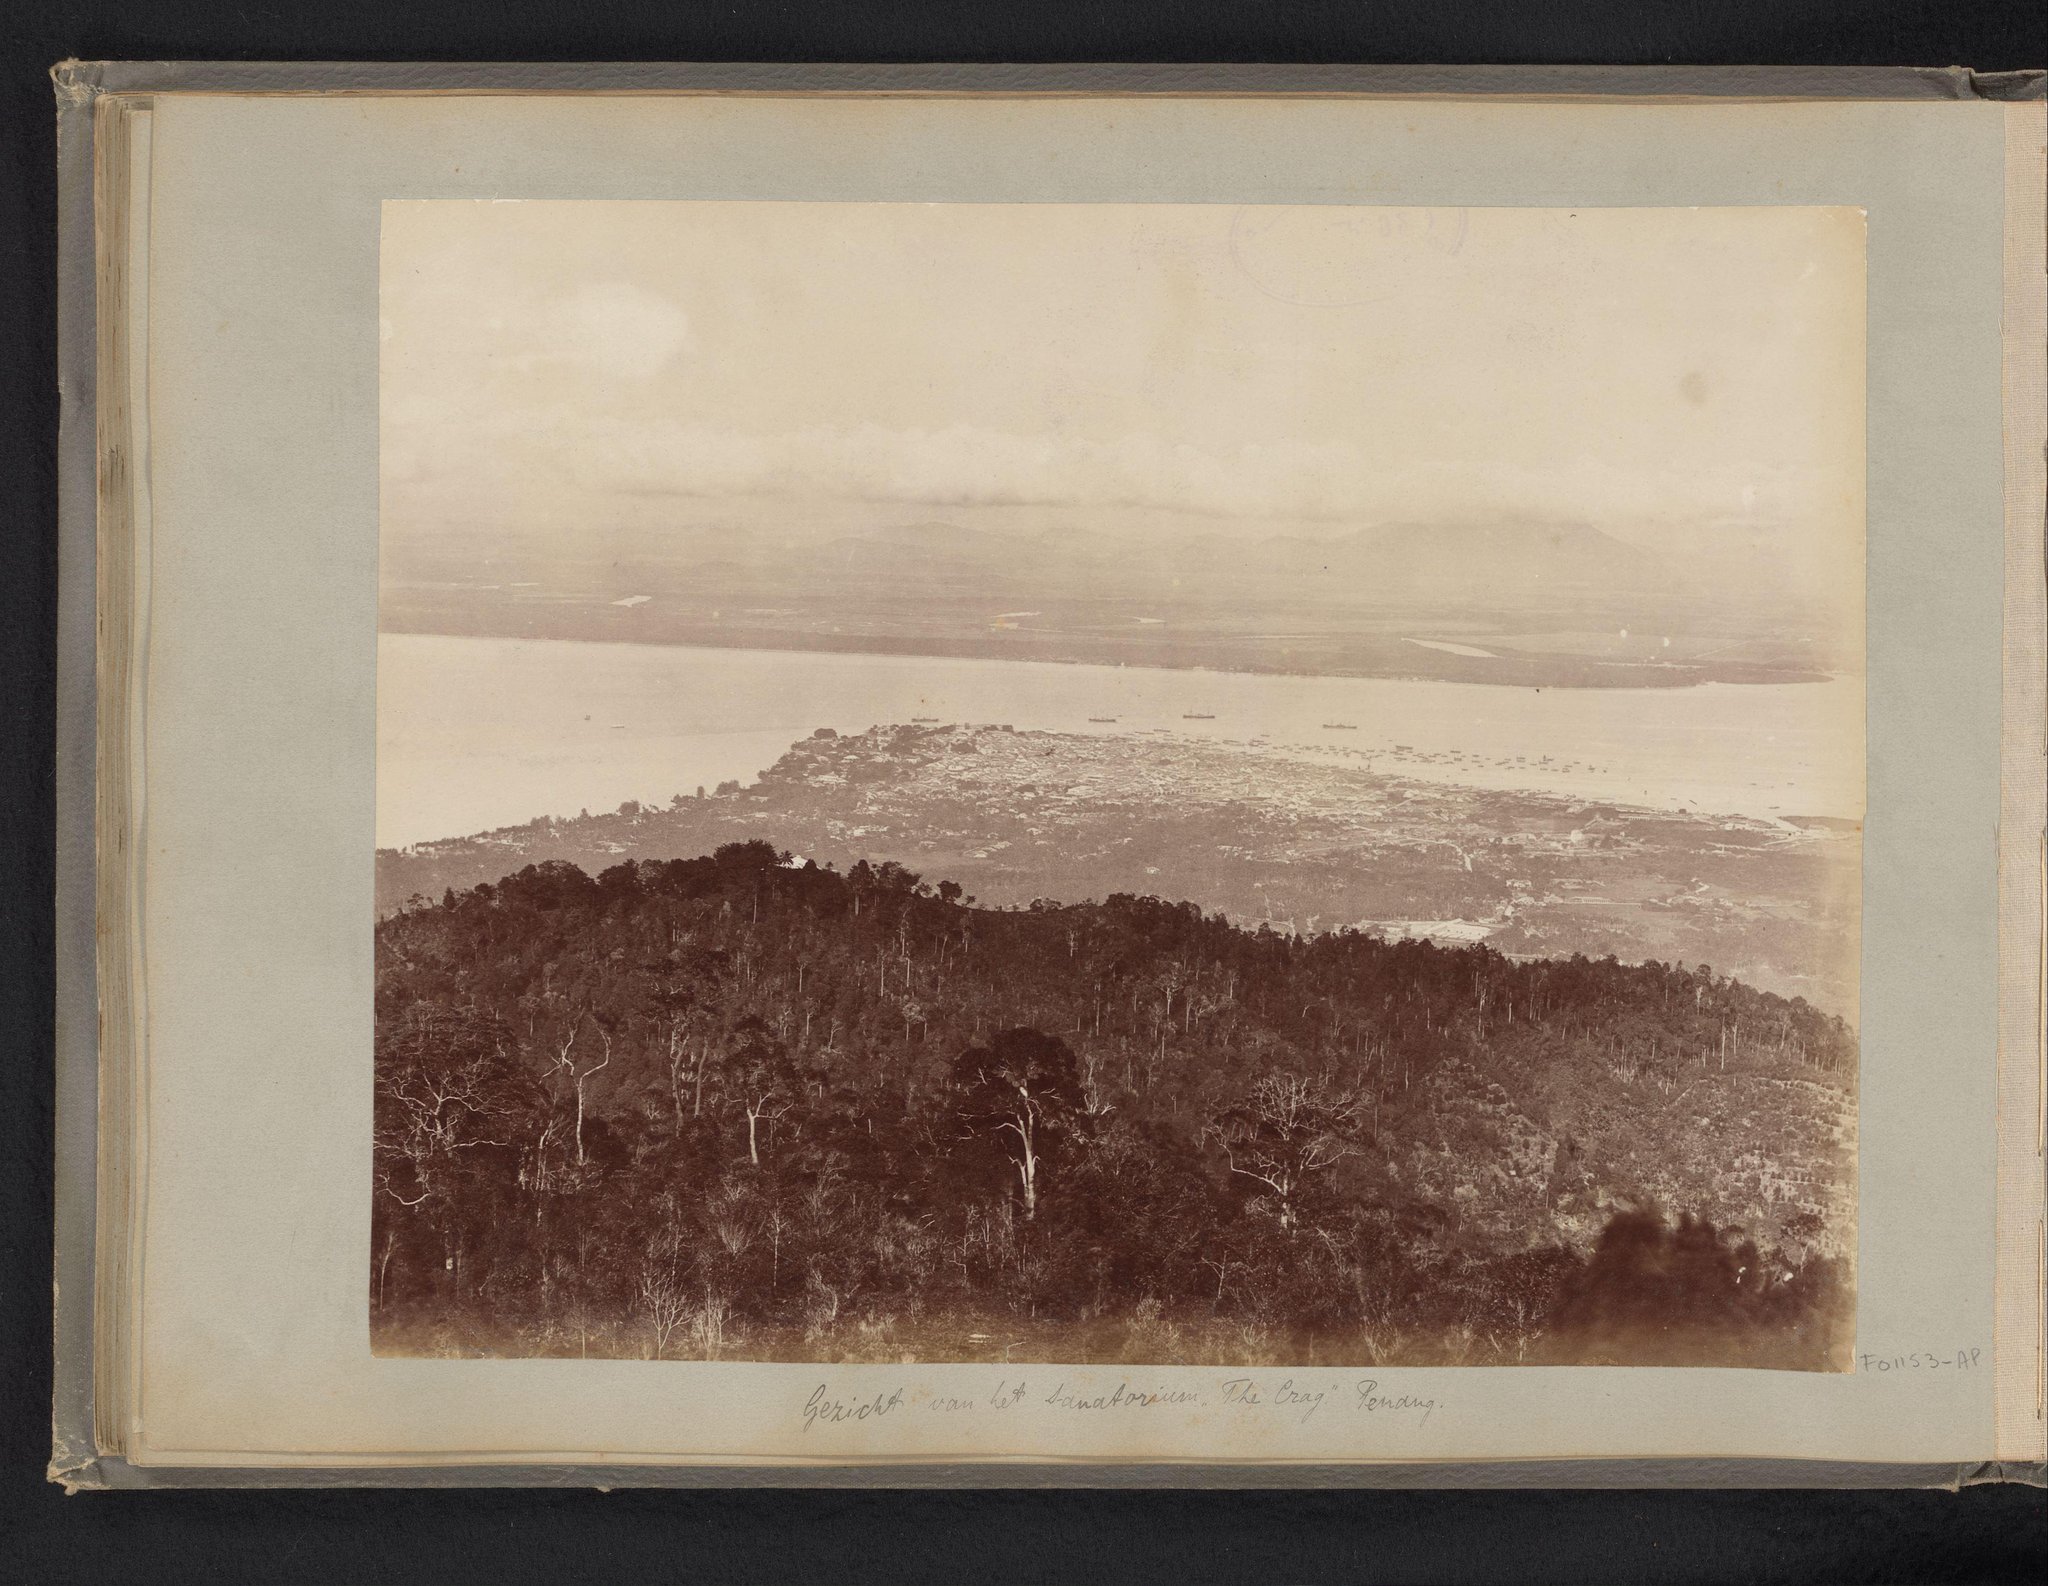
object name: album leaf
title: Uitzicht vanaf sanatorium The Crag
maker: Anonymous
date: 1892-1893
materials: photographic support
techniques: albumen print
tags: landscapes, sumatra